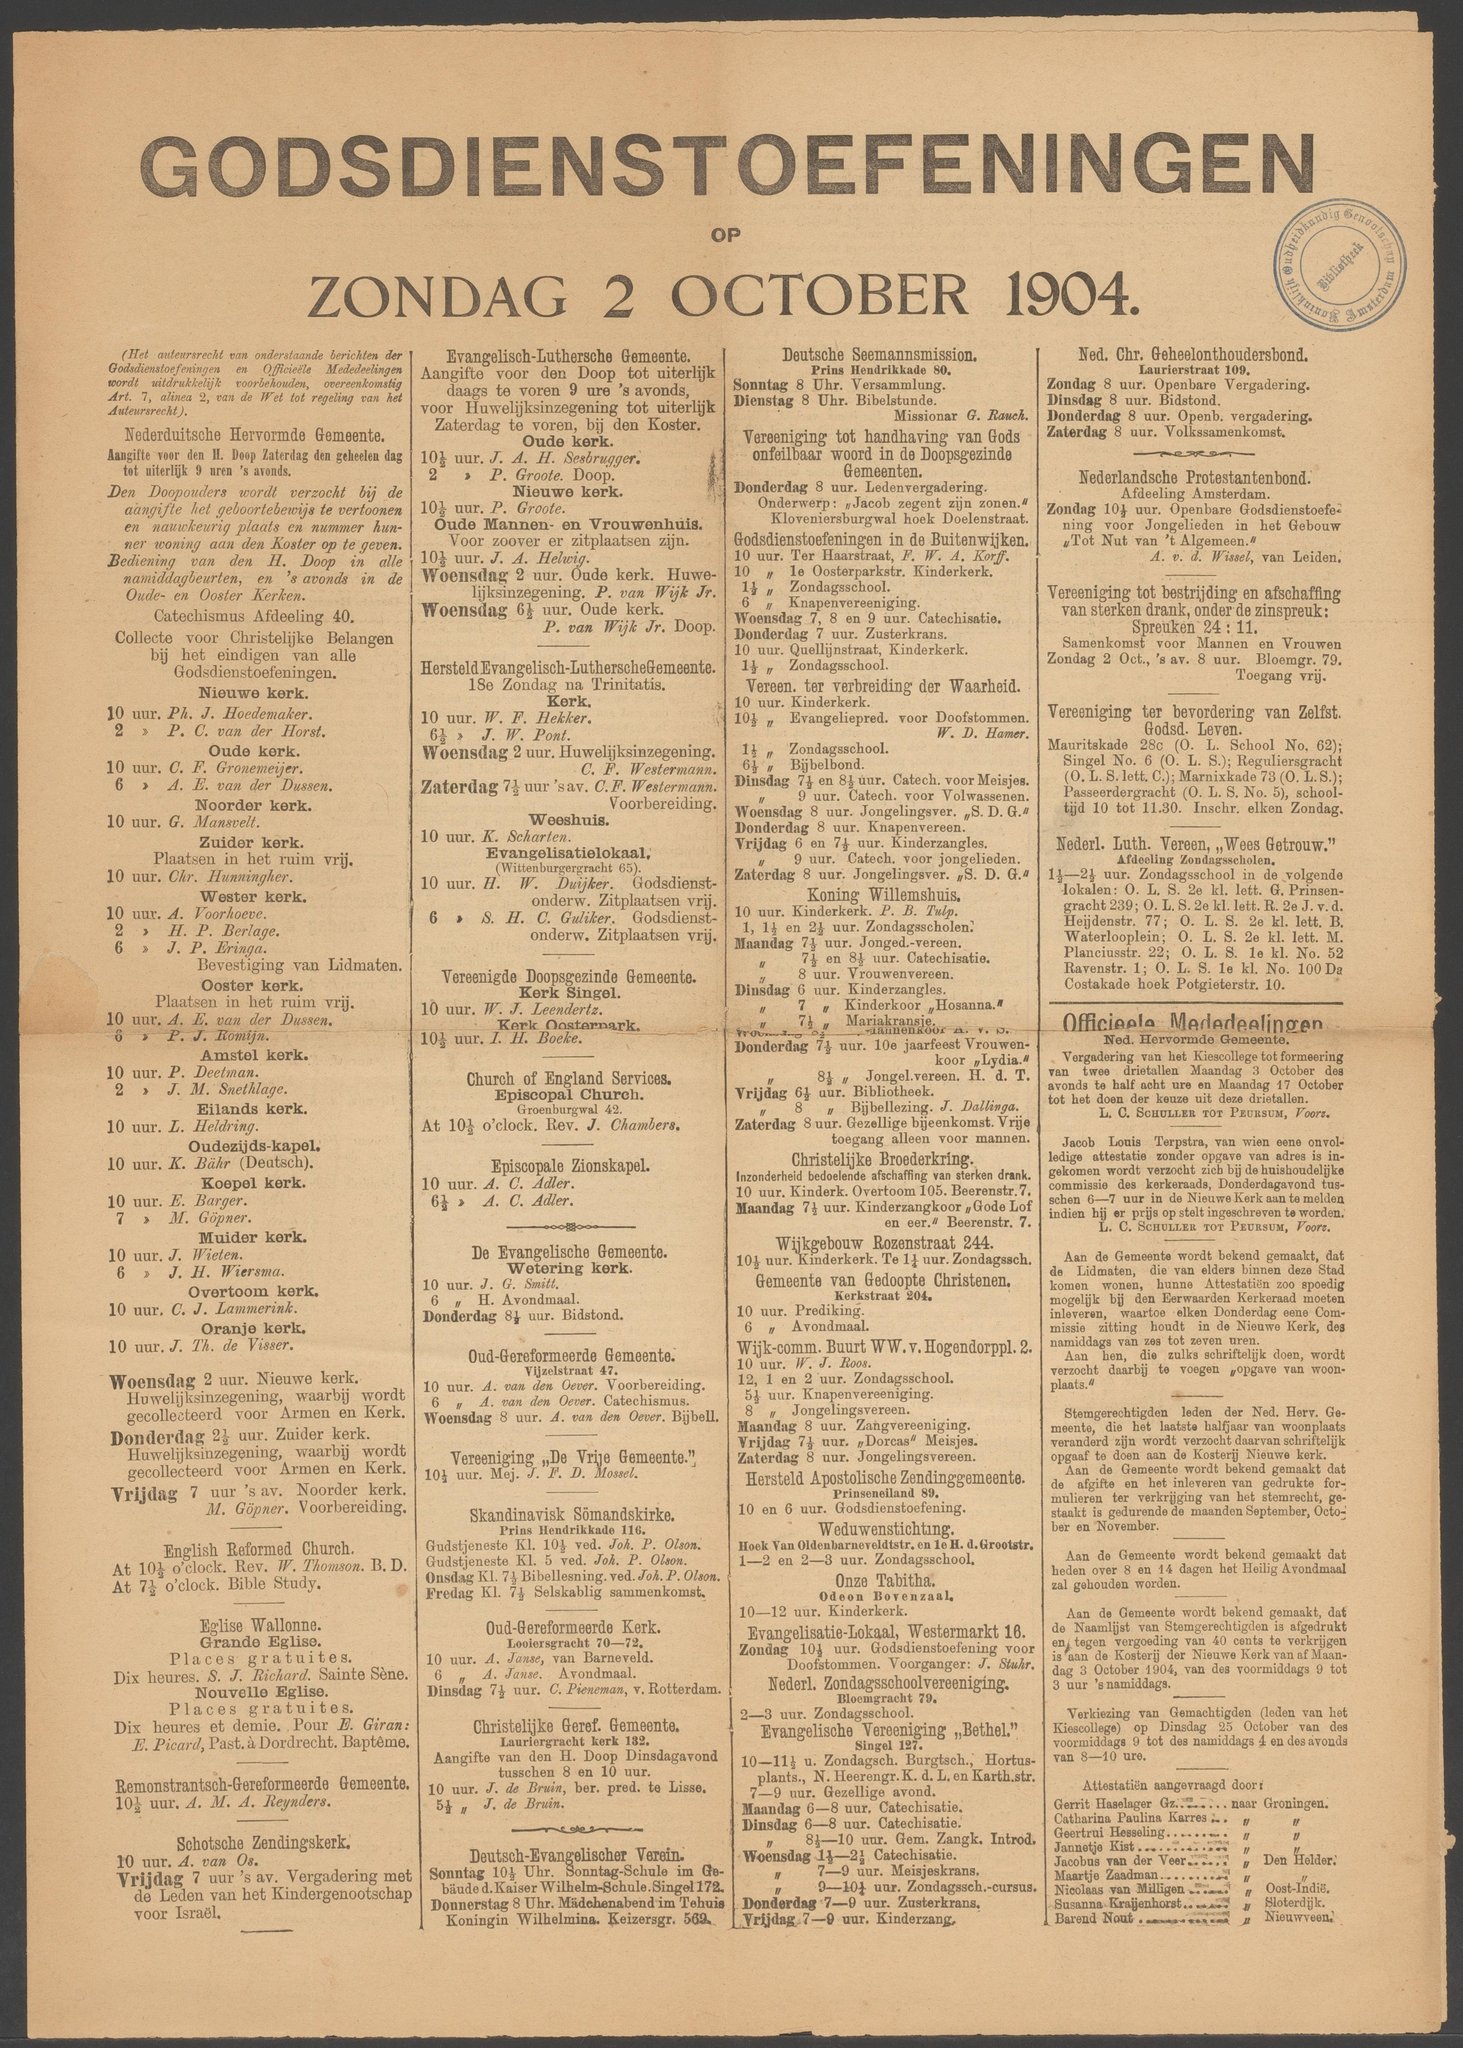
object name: photomechanical print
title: Aankondiging van Godsdienstoefeningen op 2 oktober 1904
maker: Anonymous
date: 1904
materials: paper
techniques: letterpress printing, printing block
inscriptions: collector's mark: Lugt 1641, stamp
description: Godsdienstoefening op 2 oktober 1904. Krant bestaat uit vier pagina's. Op de achterste twee pagina's staan diverse advertenties. Onderwerpsrubrieken binnen de Atlas Zeden en Gewoonten: Godsdienst, Ned. Hervormden, (Oudtijds Gereformeerden).